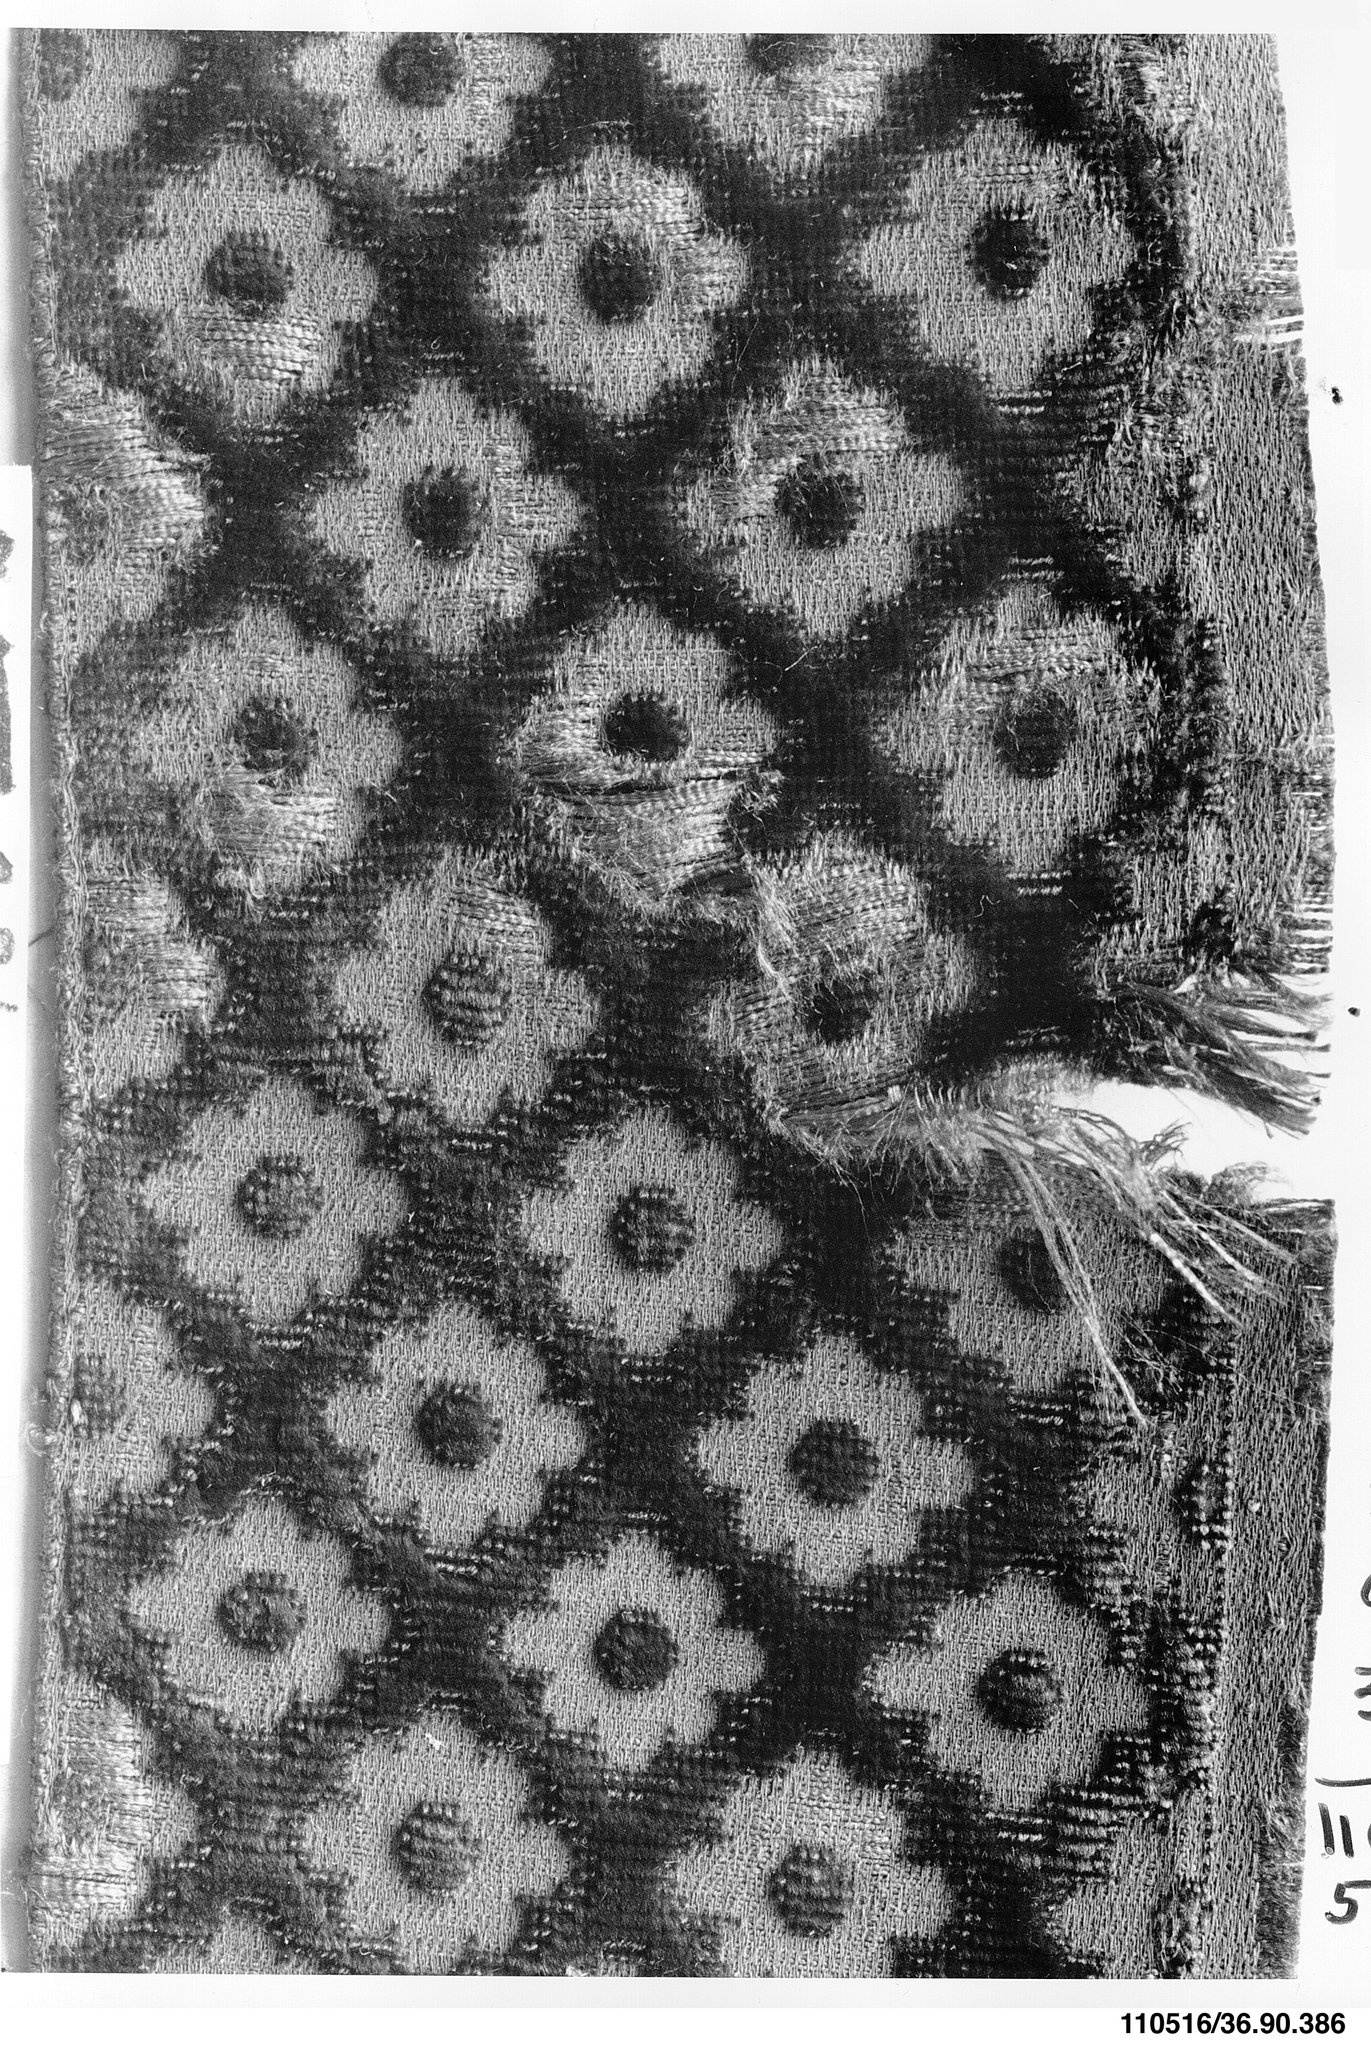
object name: piece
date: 1501-1700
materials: silk